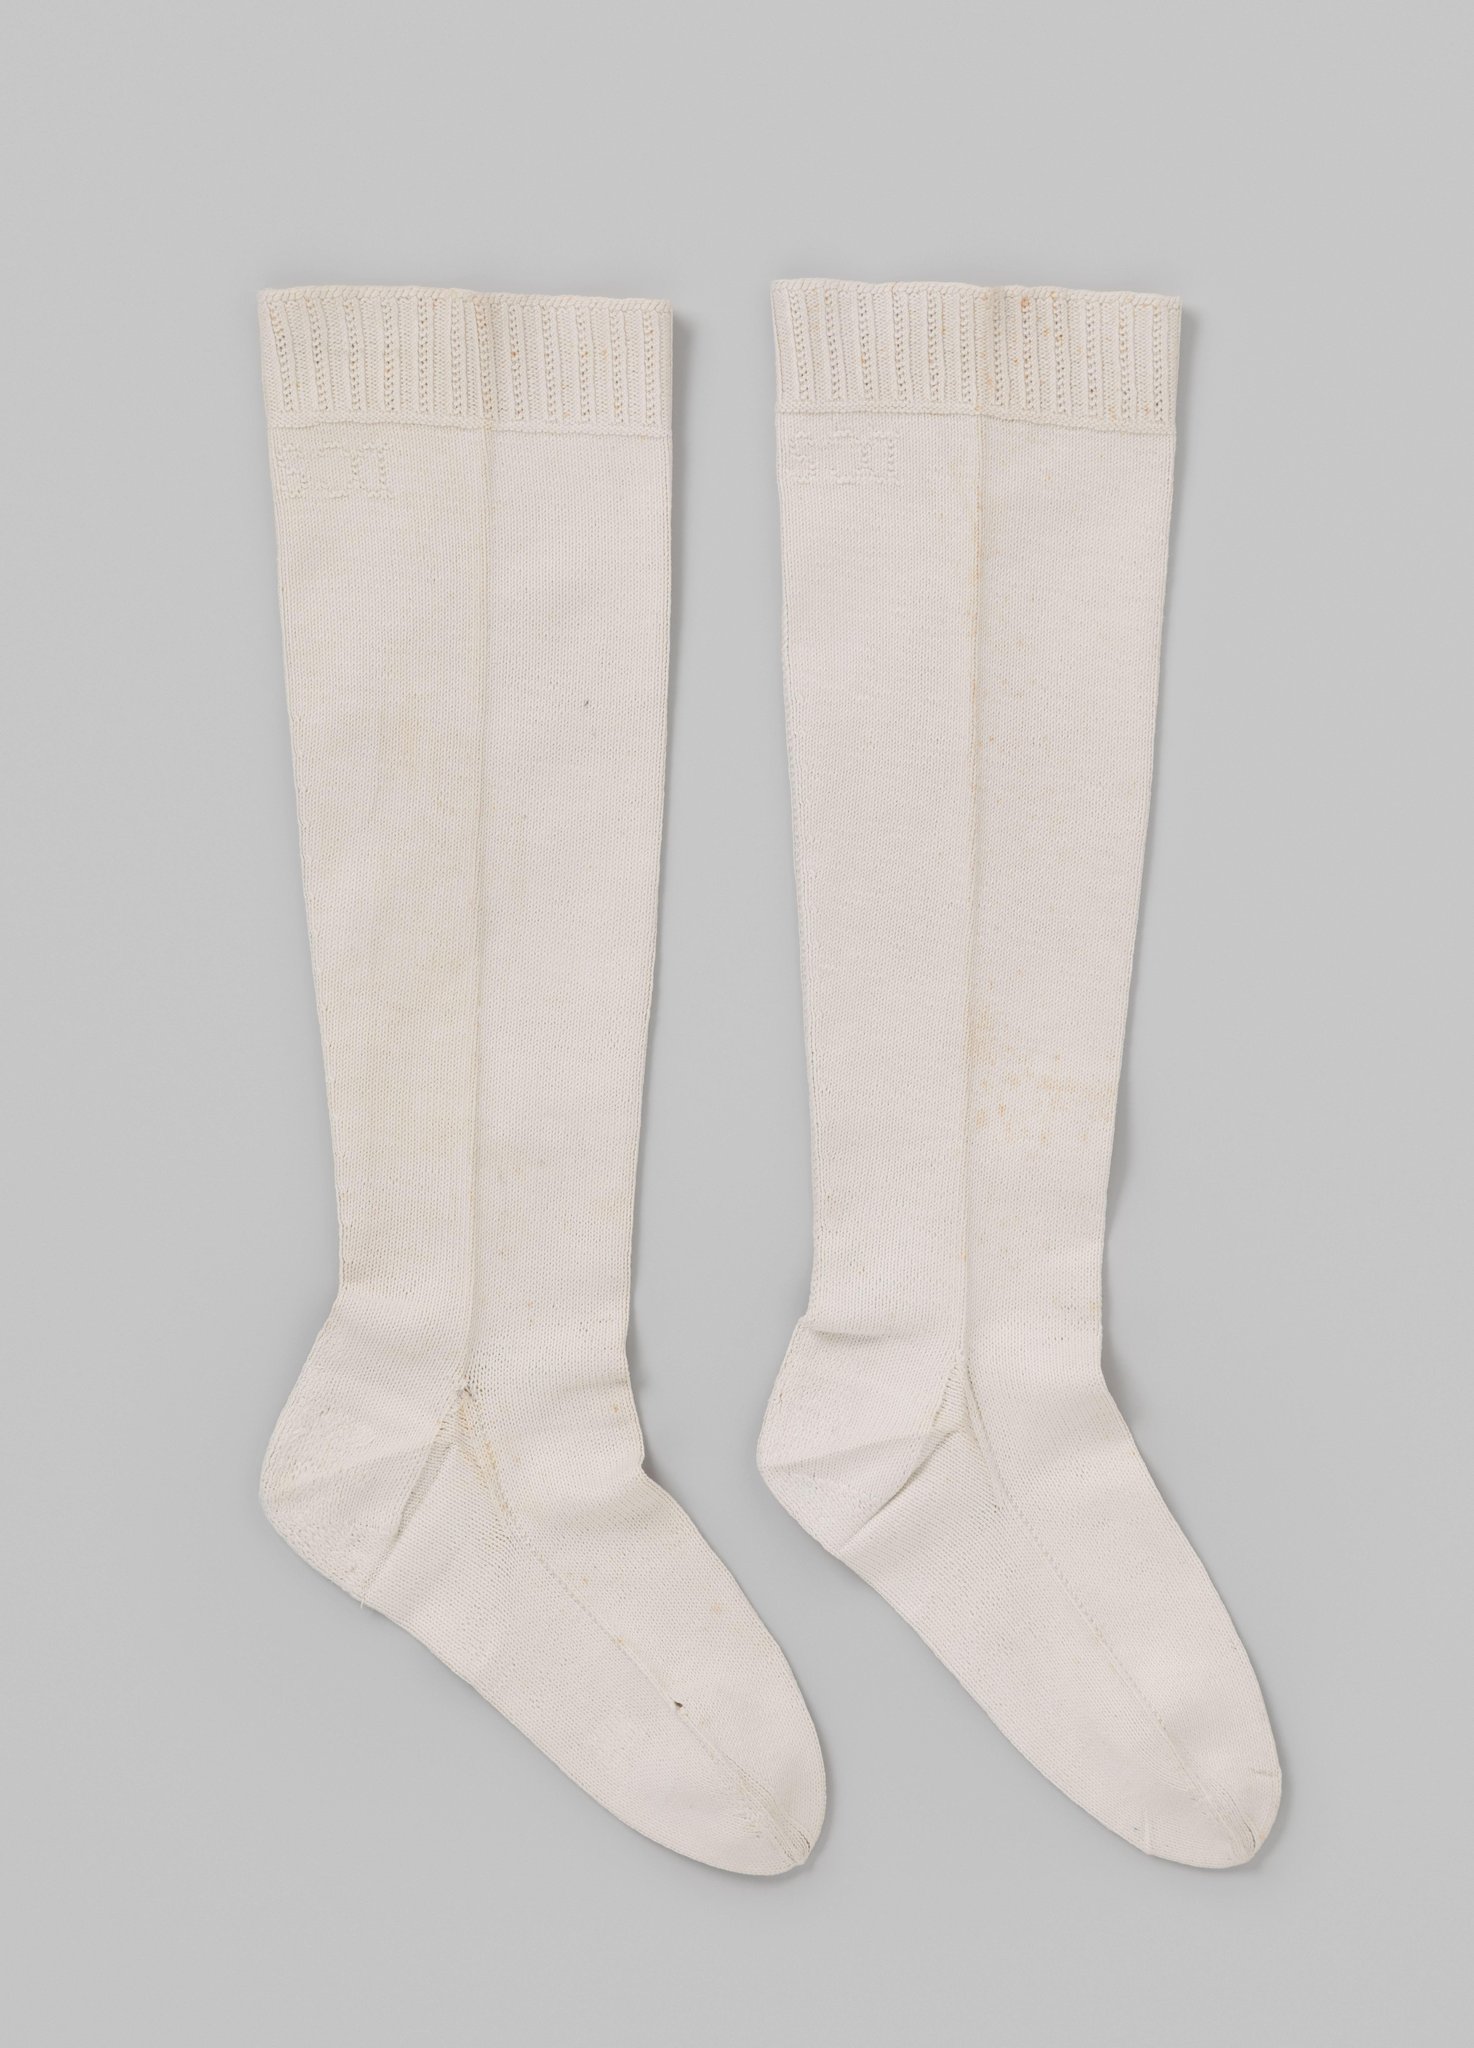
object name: childrenswear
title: Kous van effen gebreide witte katoen met smalle boord in ribsteek, kindermaat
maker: Anonymous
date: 1900-1920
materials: cotton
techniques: knitting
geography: netherlands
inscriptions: mark: ‘'DCS 6'’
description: Kous van effen gebreide witte katoen met smalle boord in ribsteek, kindermaat. Gemerkt: 'DCS 6'.